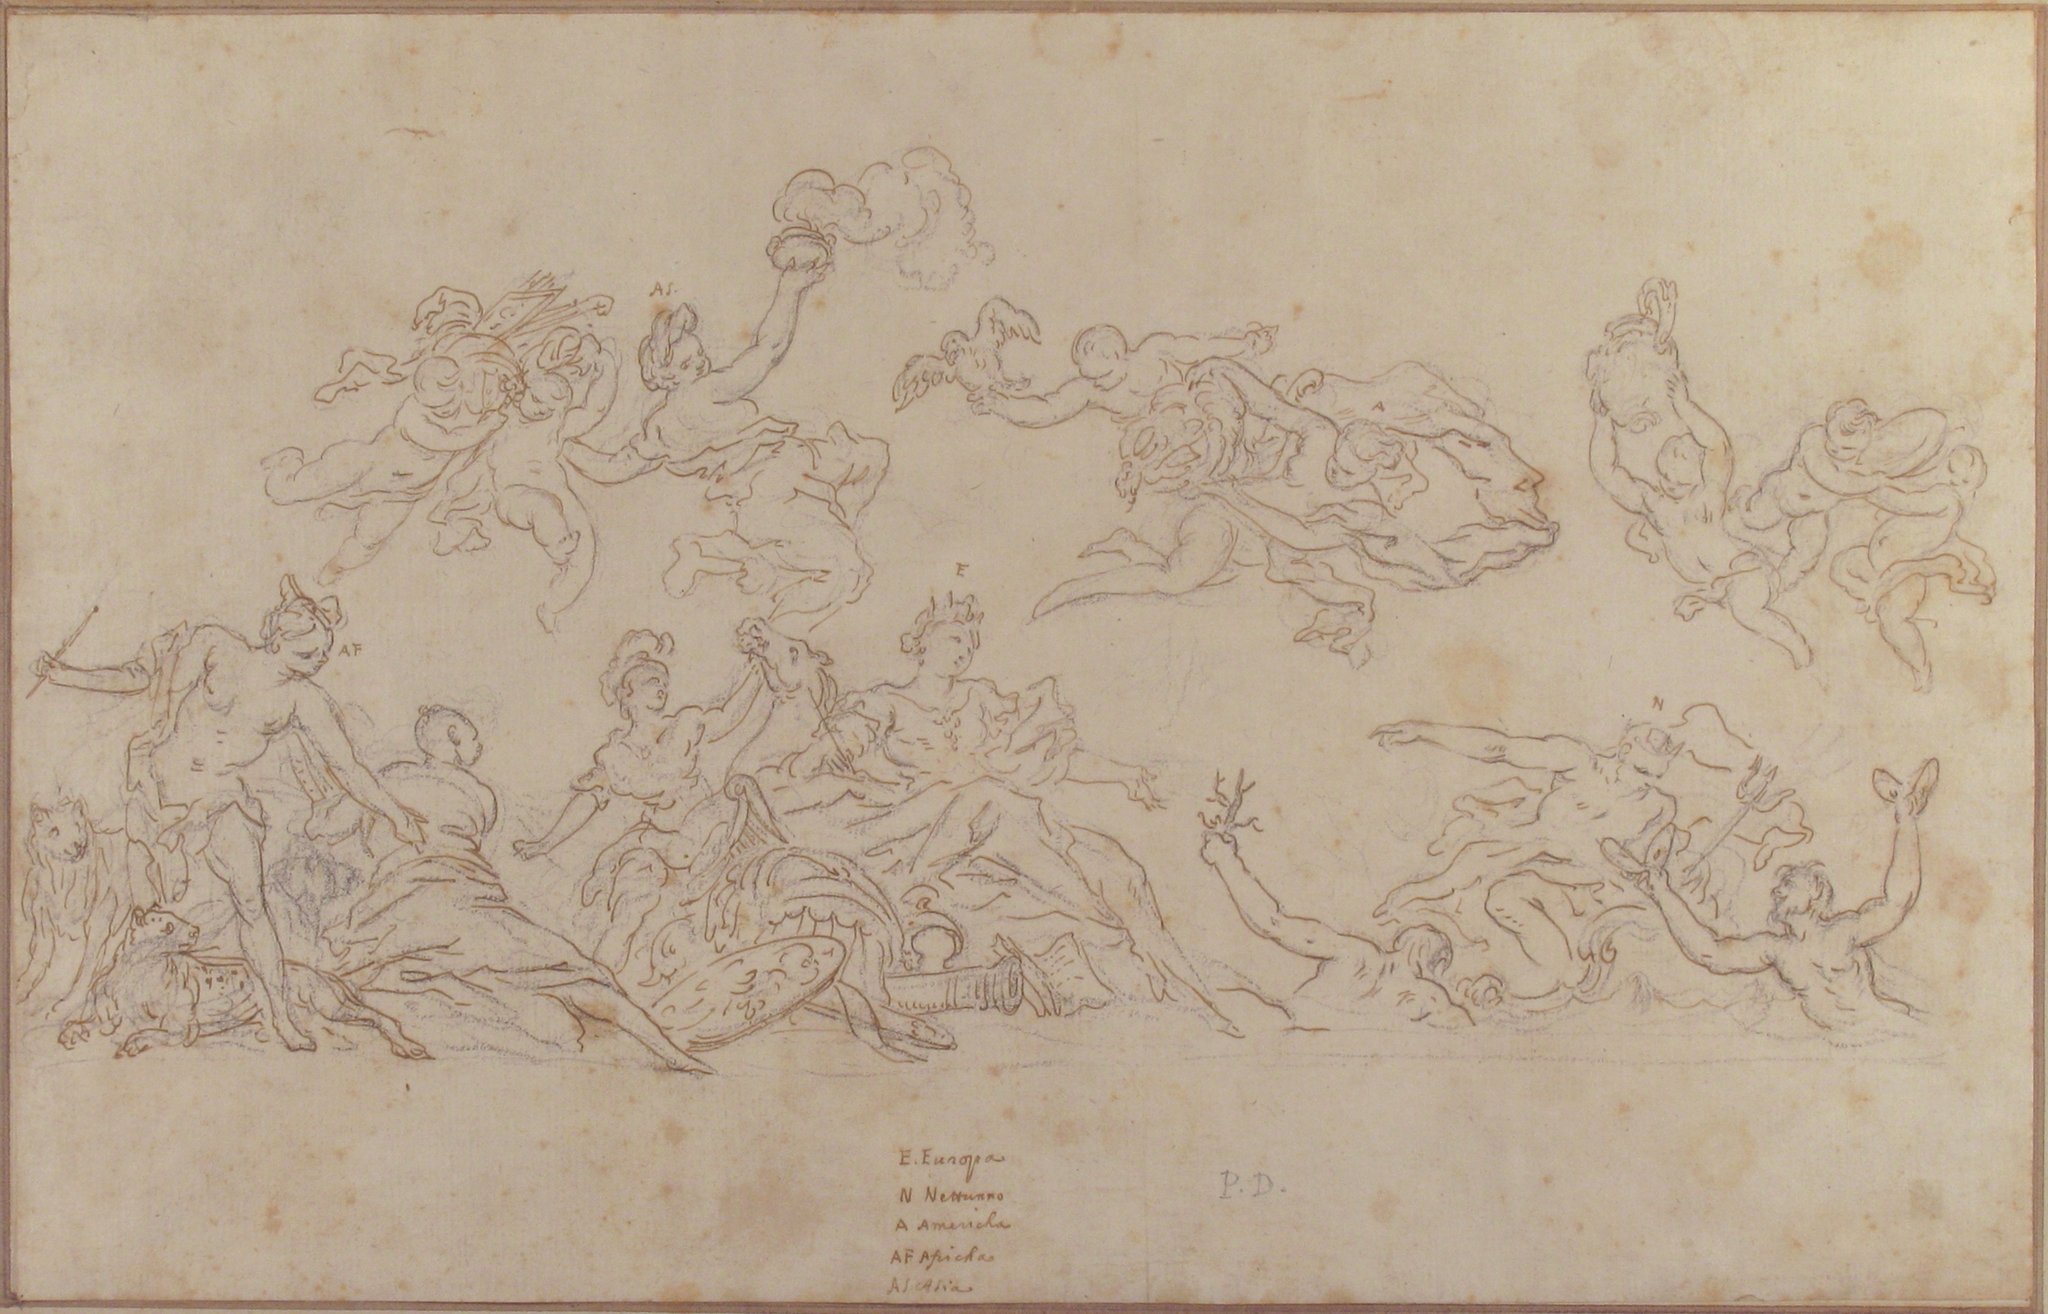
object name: drawing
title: Design for a Ceiling Decoration with Neptune and Allegories of the Four Continents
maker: pietro dandini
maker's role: artist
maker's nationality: italian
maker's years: 1646-1712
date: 1646-1712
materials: chalk, ink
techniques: pen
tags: neptune,ceilings